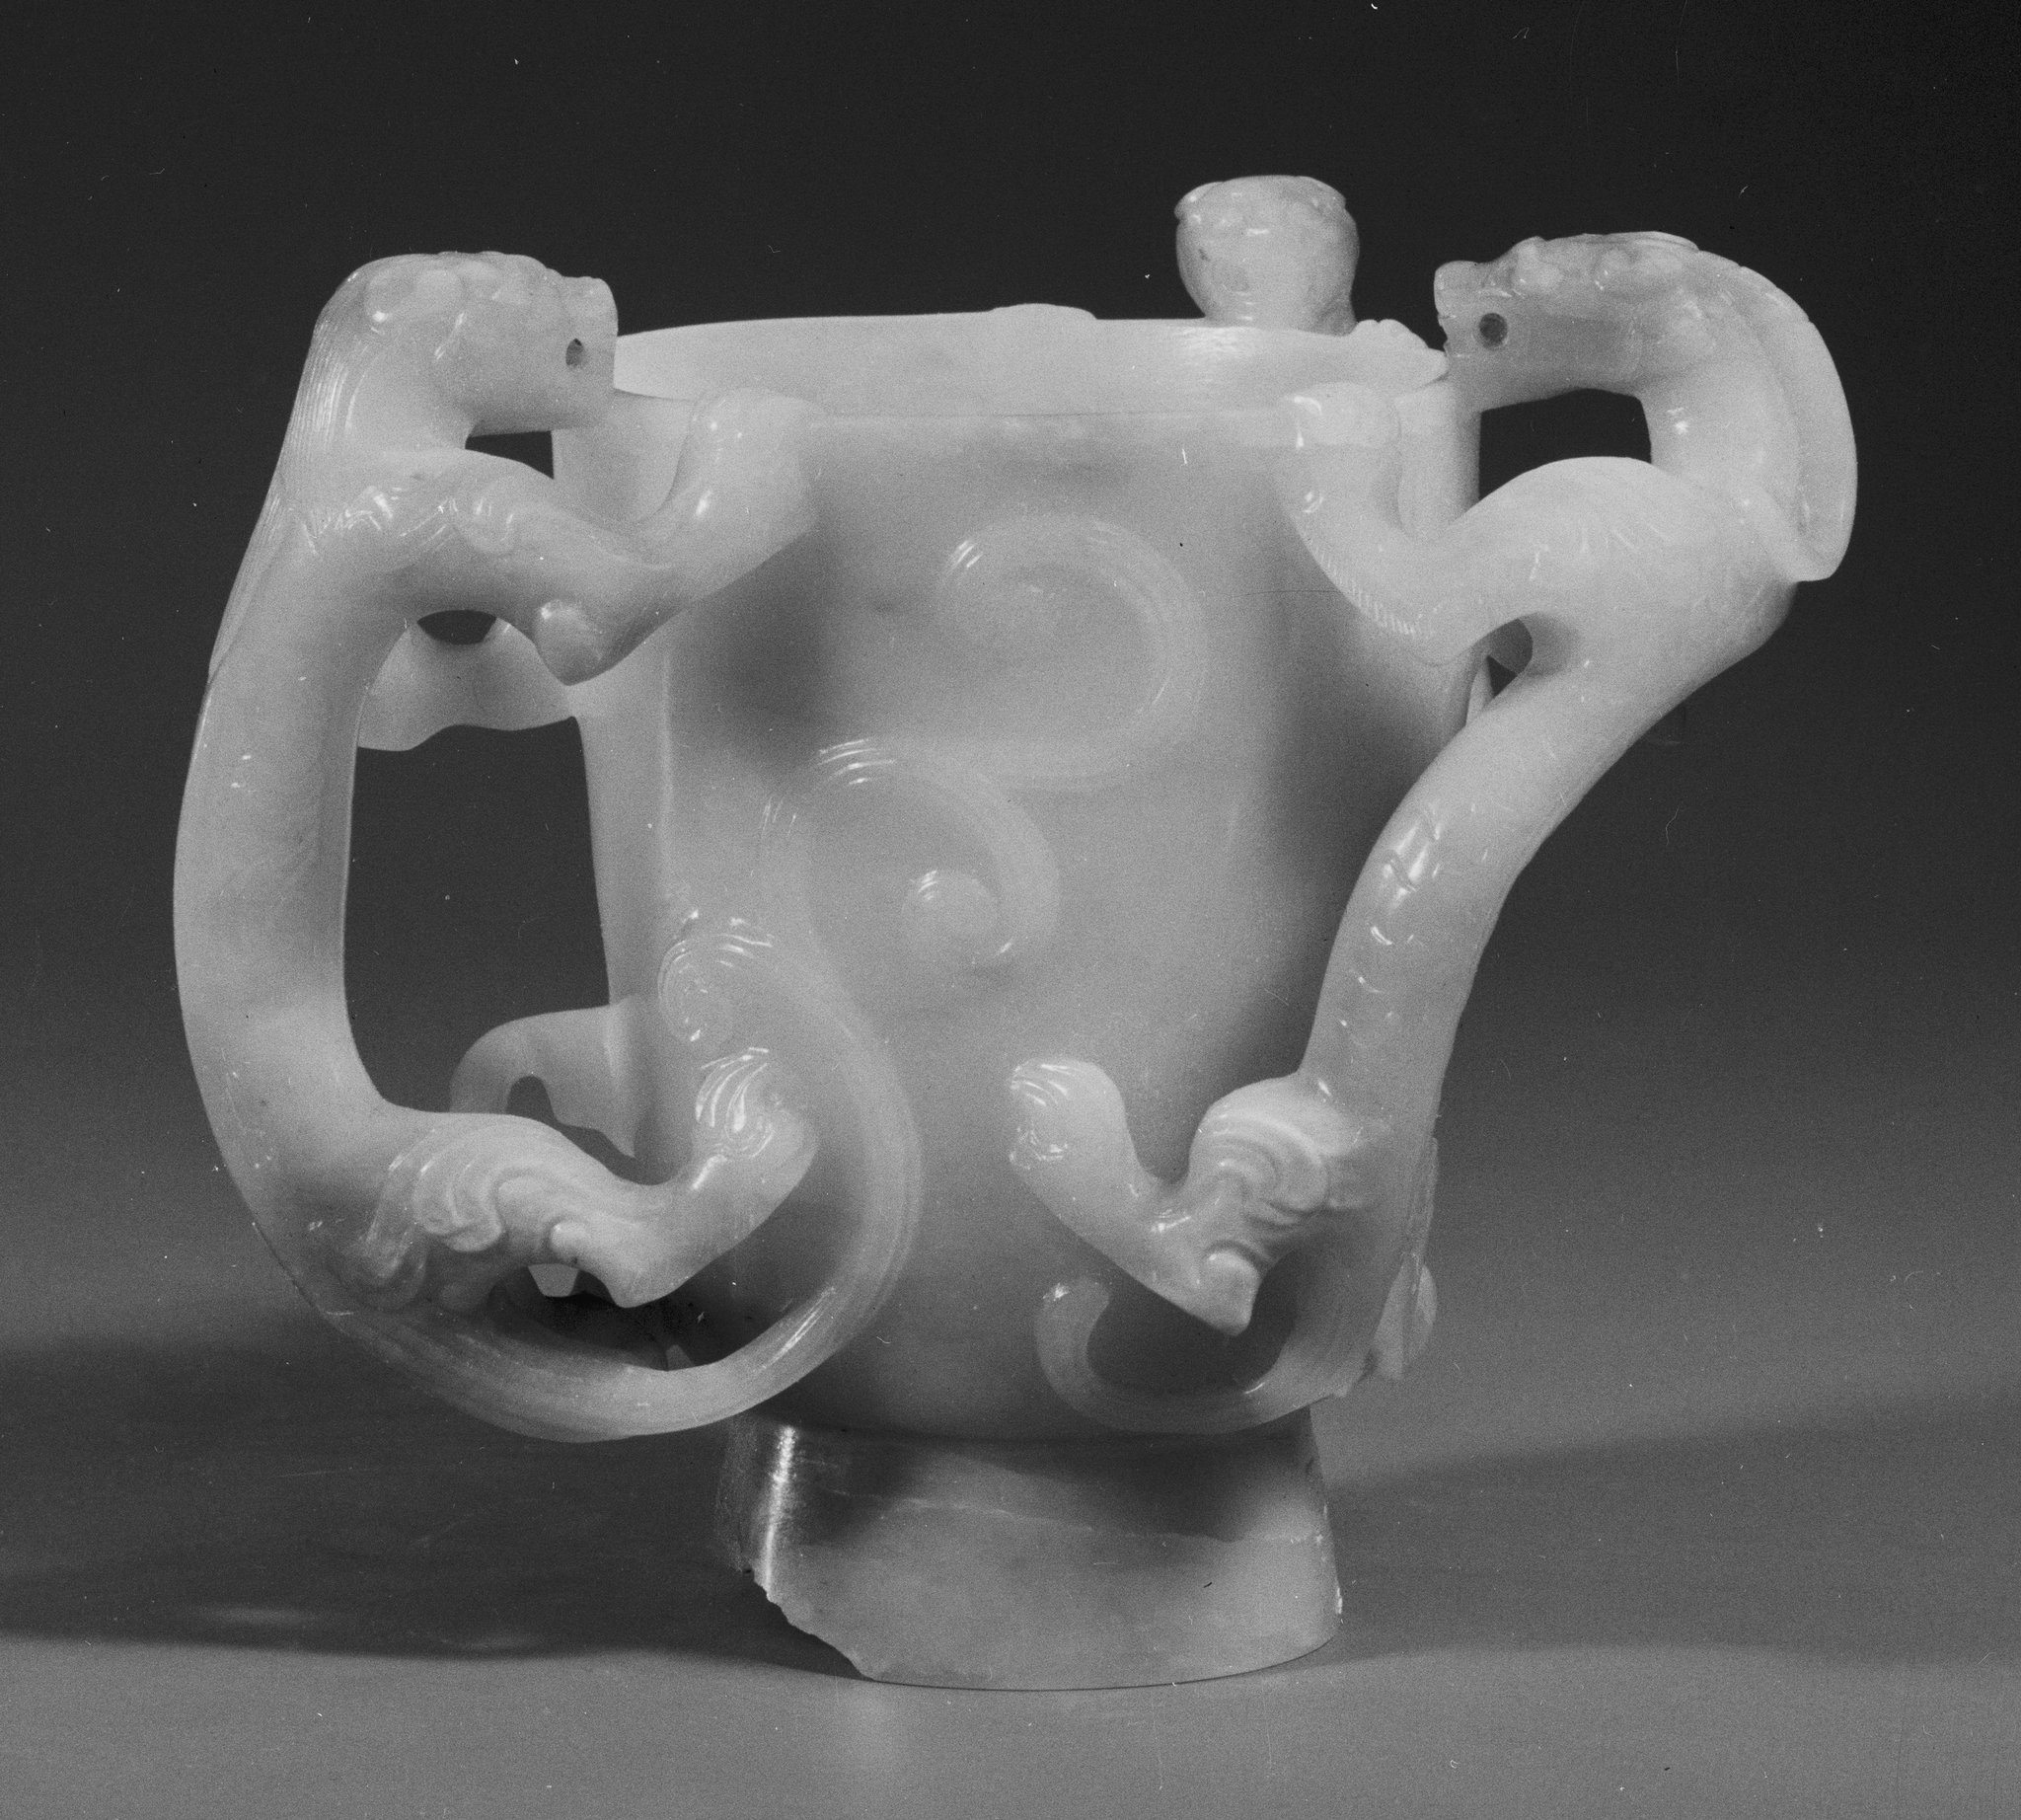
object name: cup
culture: chinese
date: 1701-1900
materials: jade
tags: animals